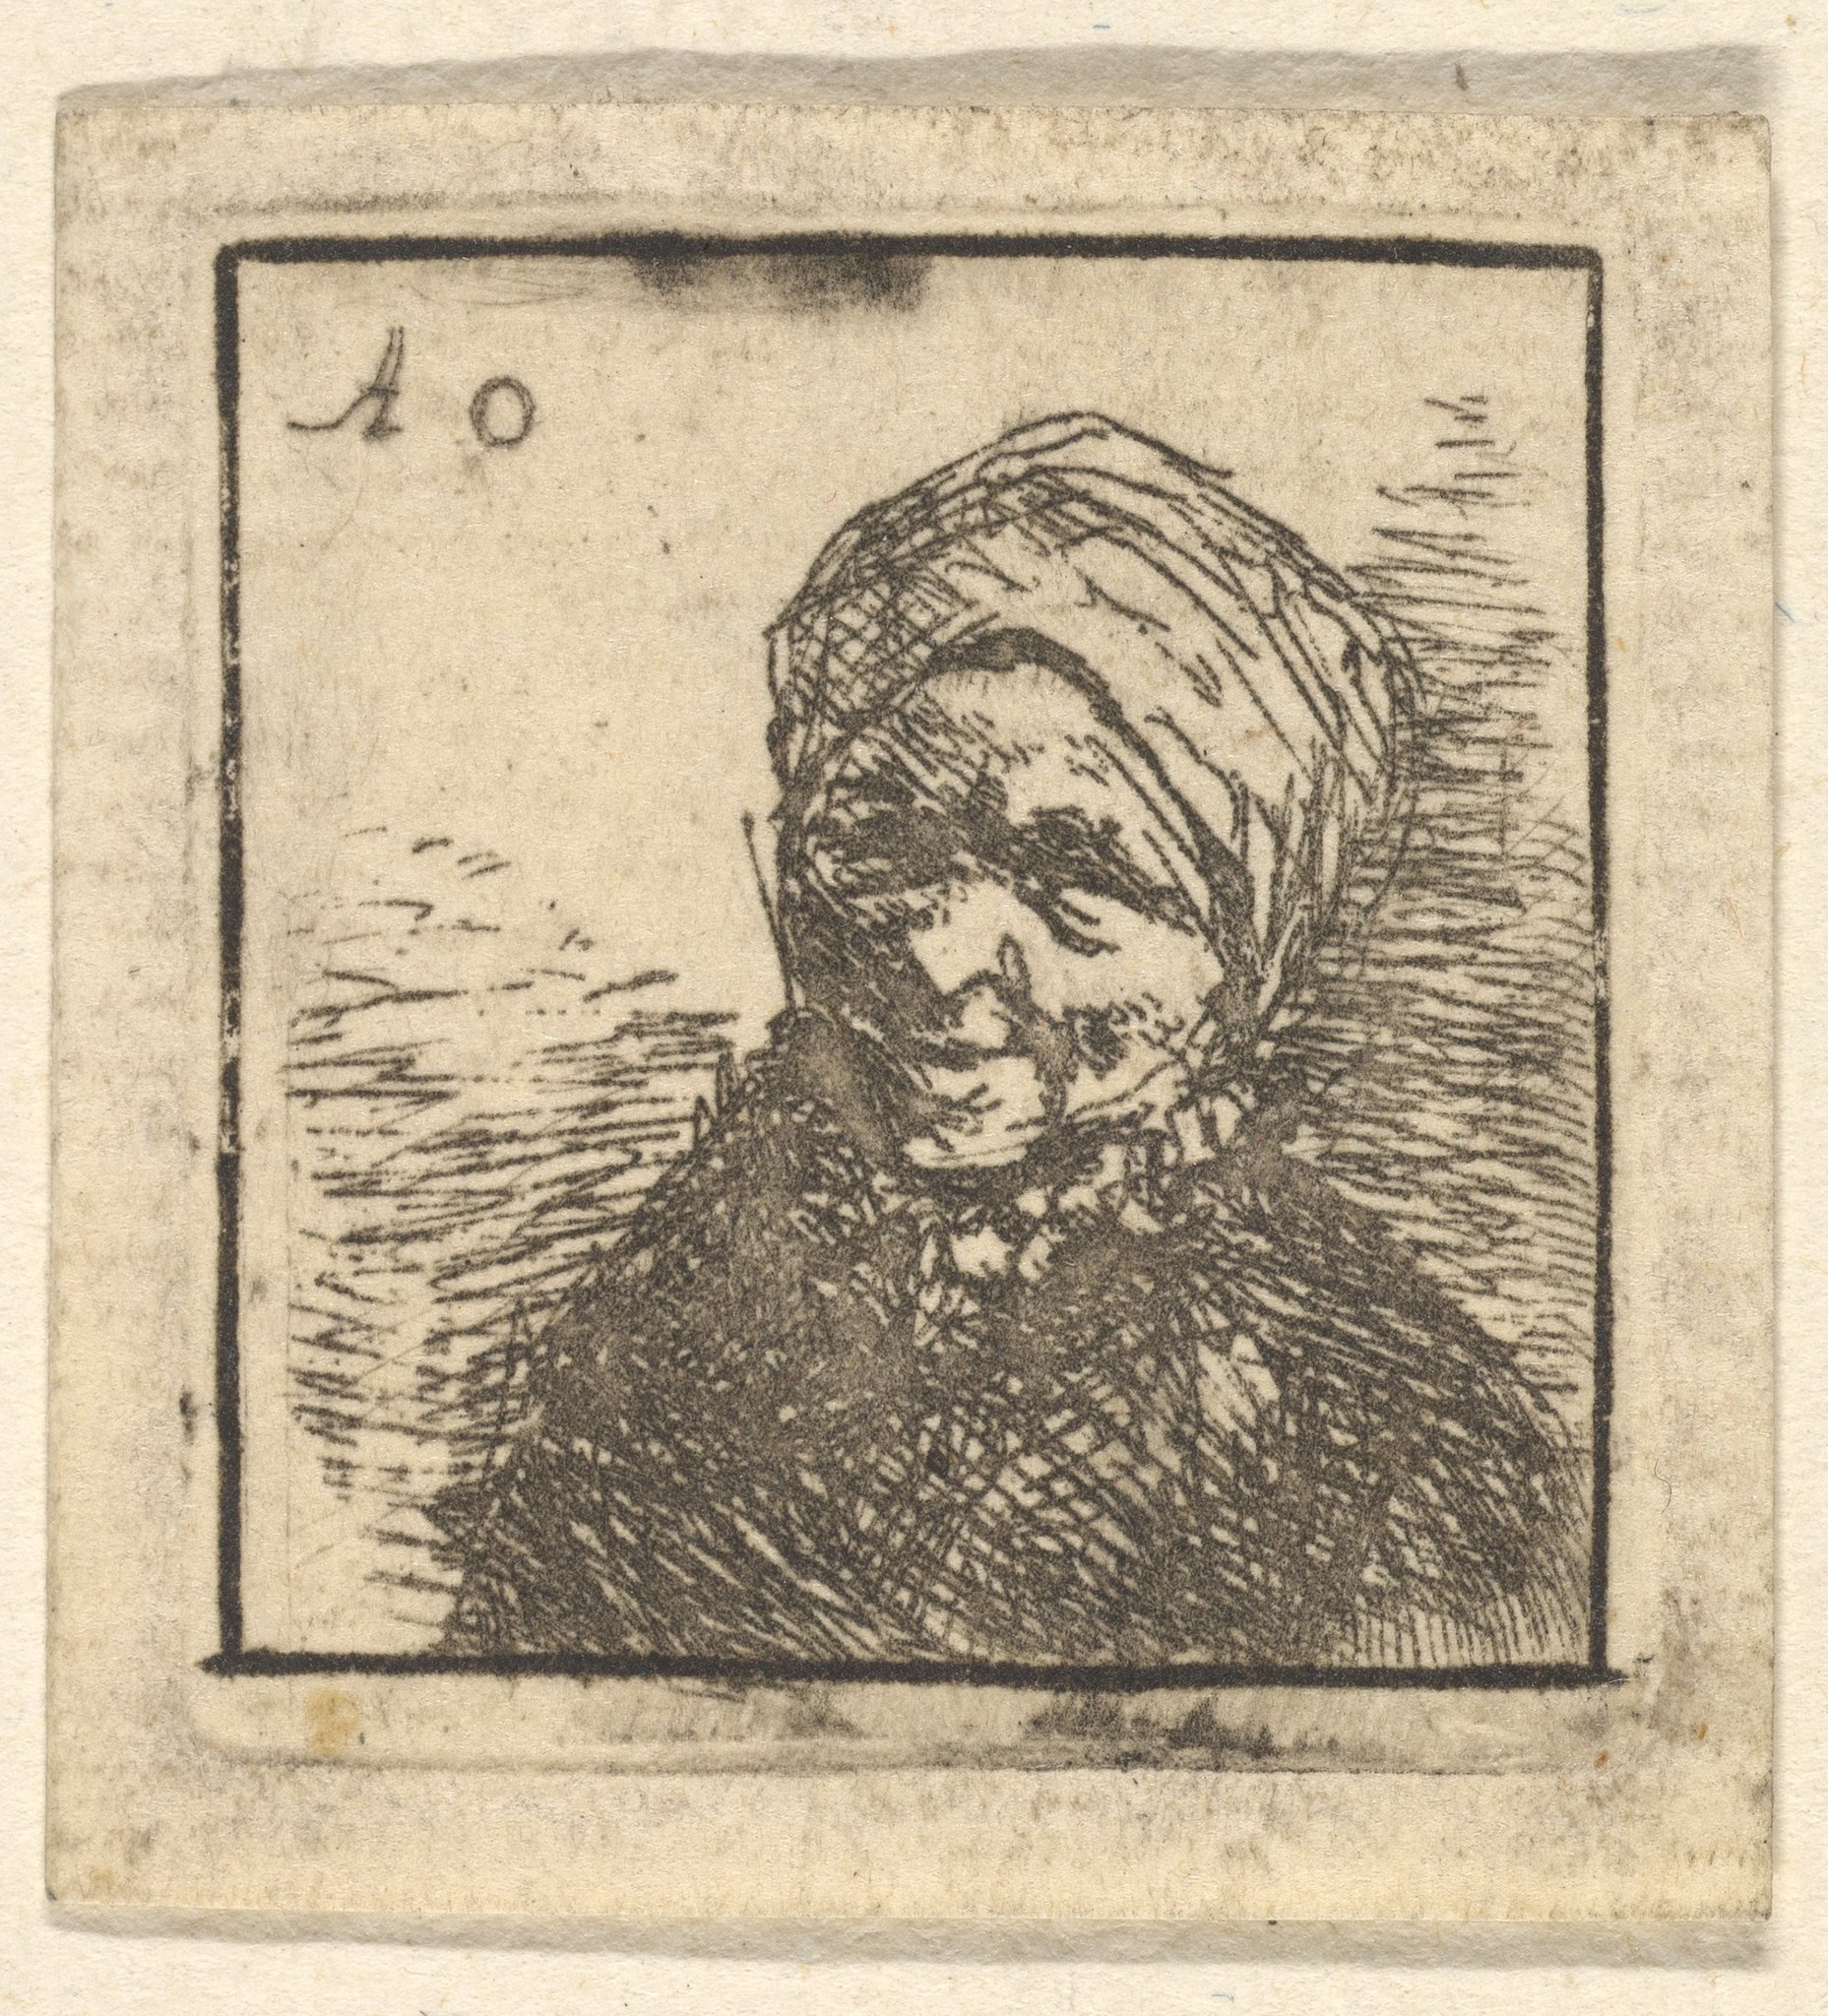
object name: print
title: Peasant Woman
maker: adriaen van ostade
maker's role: artist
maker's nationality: dutch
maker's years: 1610-1685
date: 1610-1685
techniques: etching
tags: portraits,women